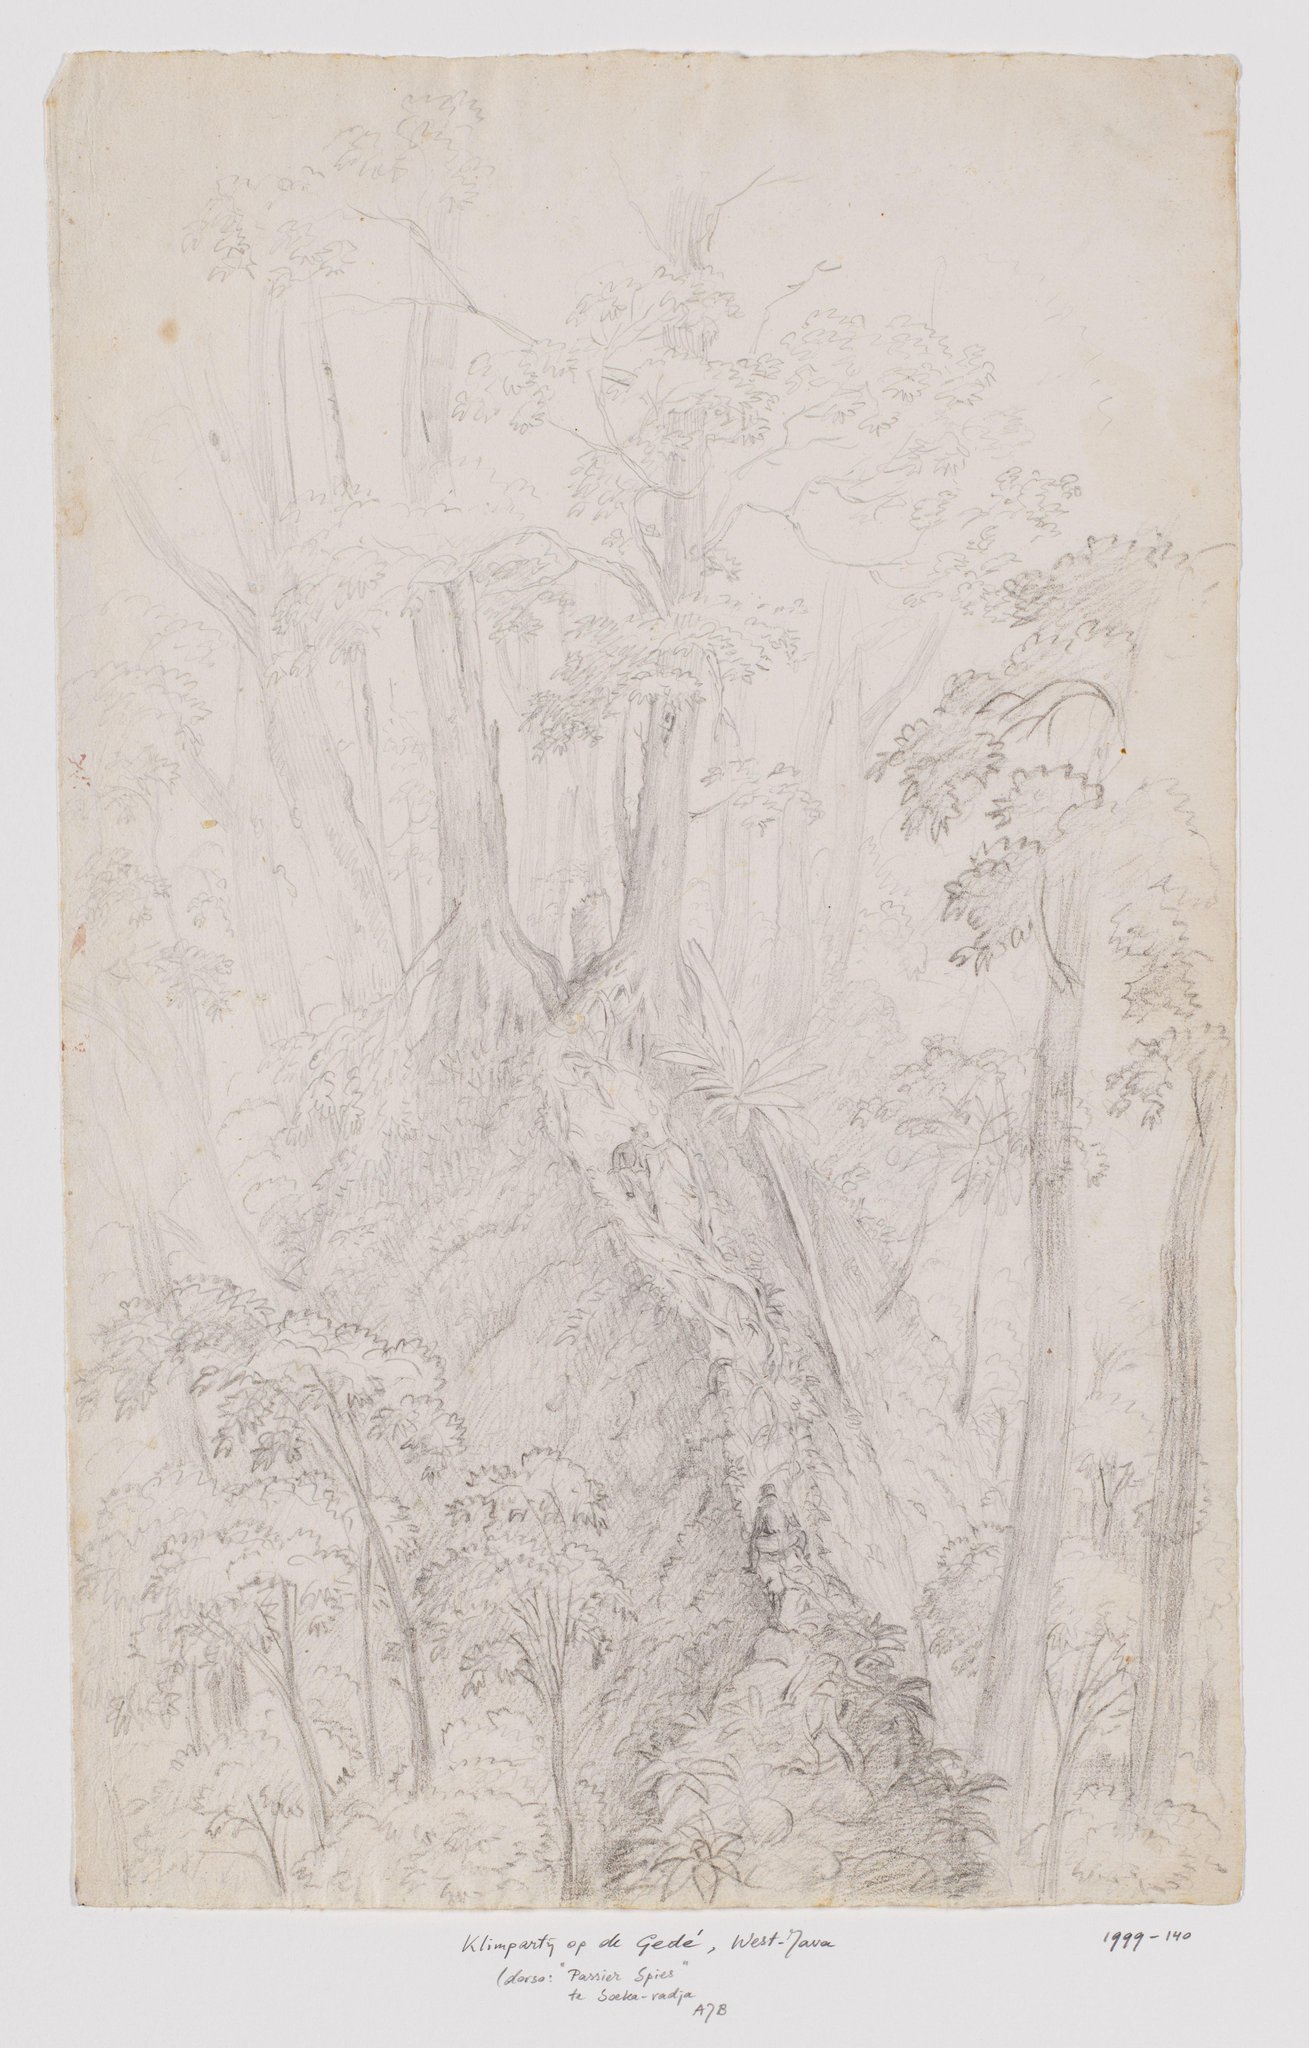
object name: drawing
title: Beklimming van de vulkaan Gedé, Priangan, West-Java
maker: adrianus johannes bik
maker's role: draughtsman, print maker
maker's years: 1790-1872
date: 1819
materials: chalk, paper, pencil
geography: west java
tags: caspar georg carl reinwardt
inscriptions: annotation: ‘A.Bik del Soukaradja’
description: Tekening gemaakt tijdens de expeditie van Reinwardt en zijn gevolg in 1819.